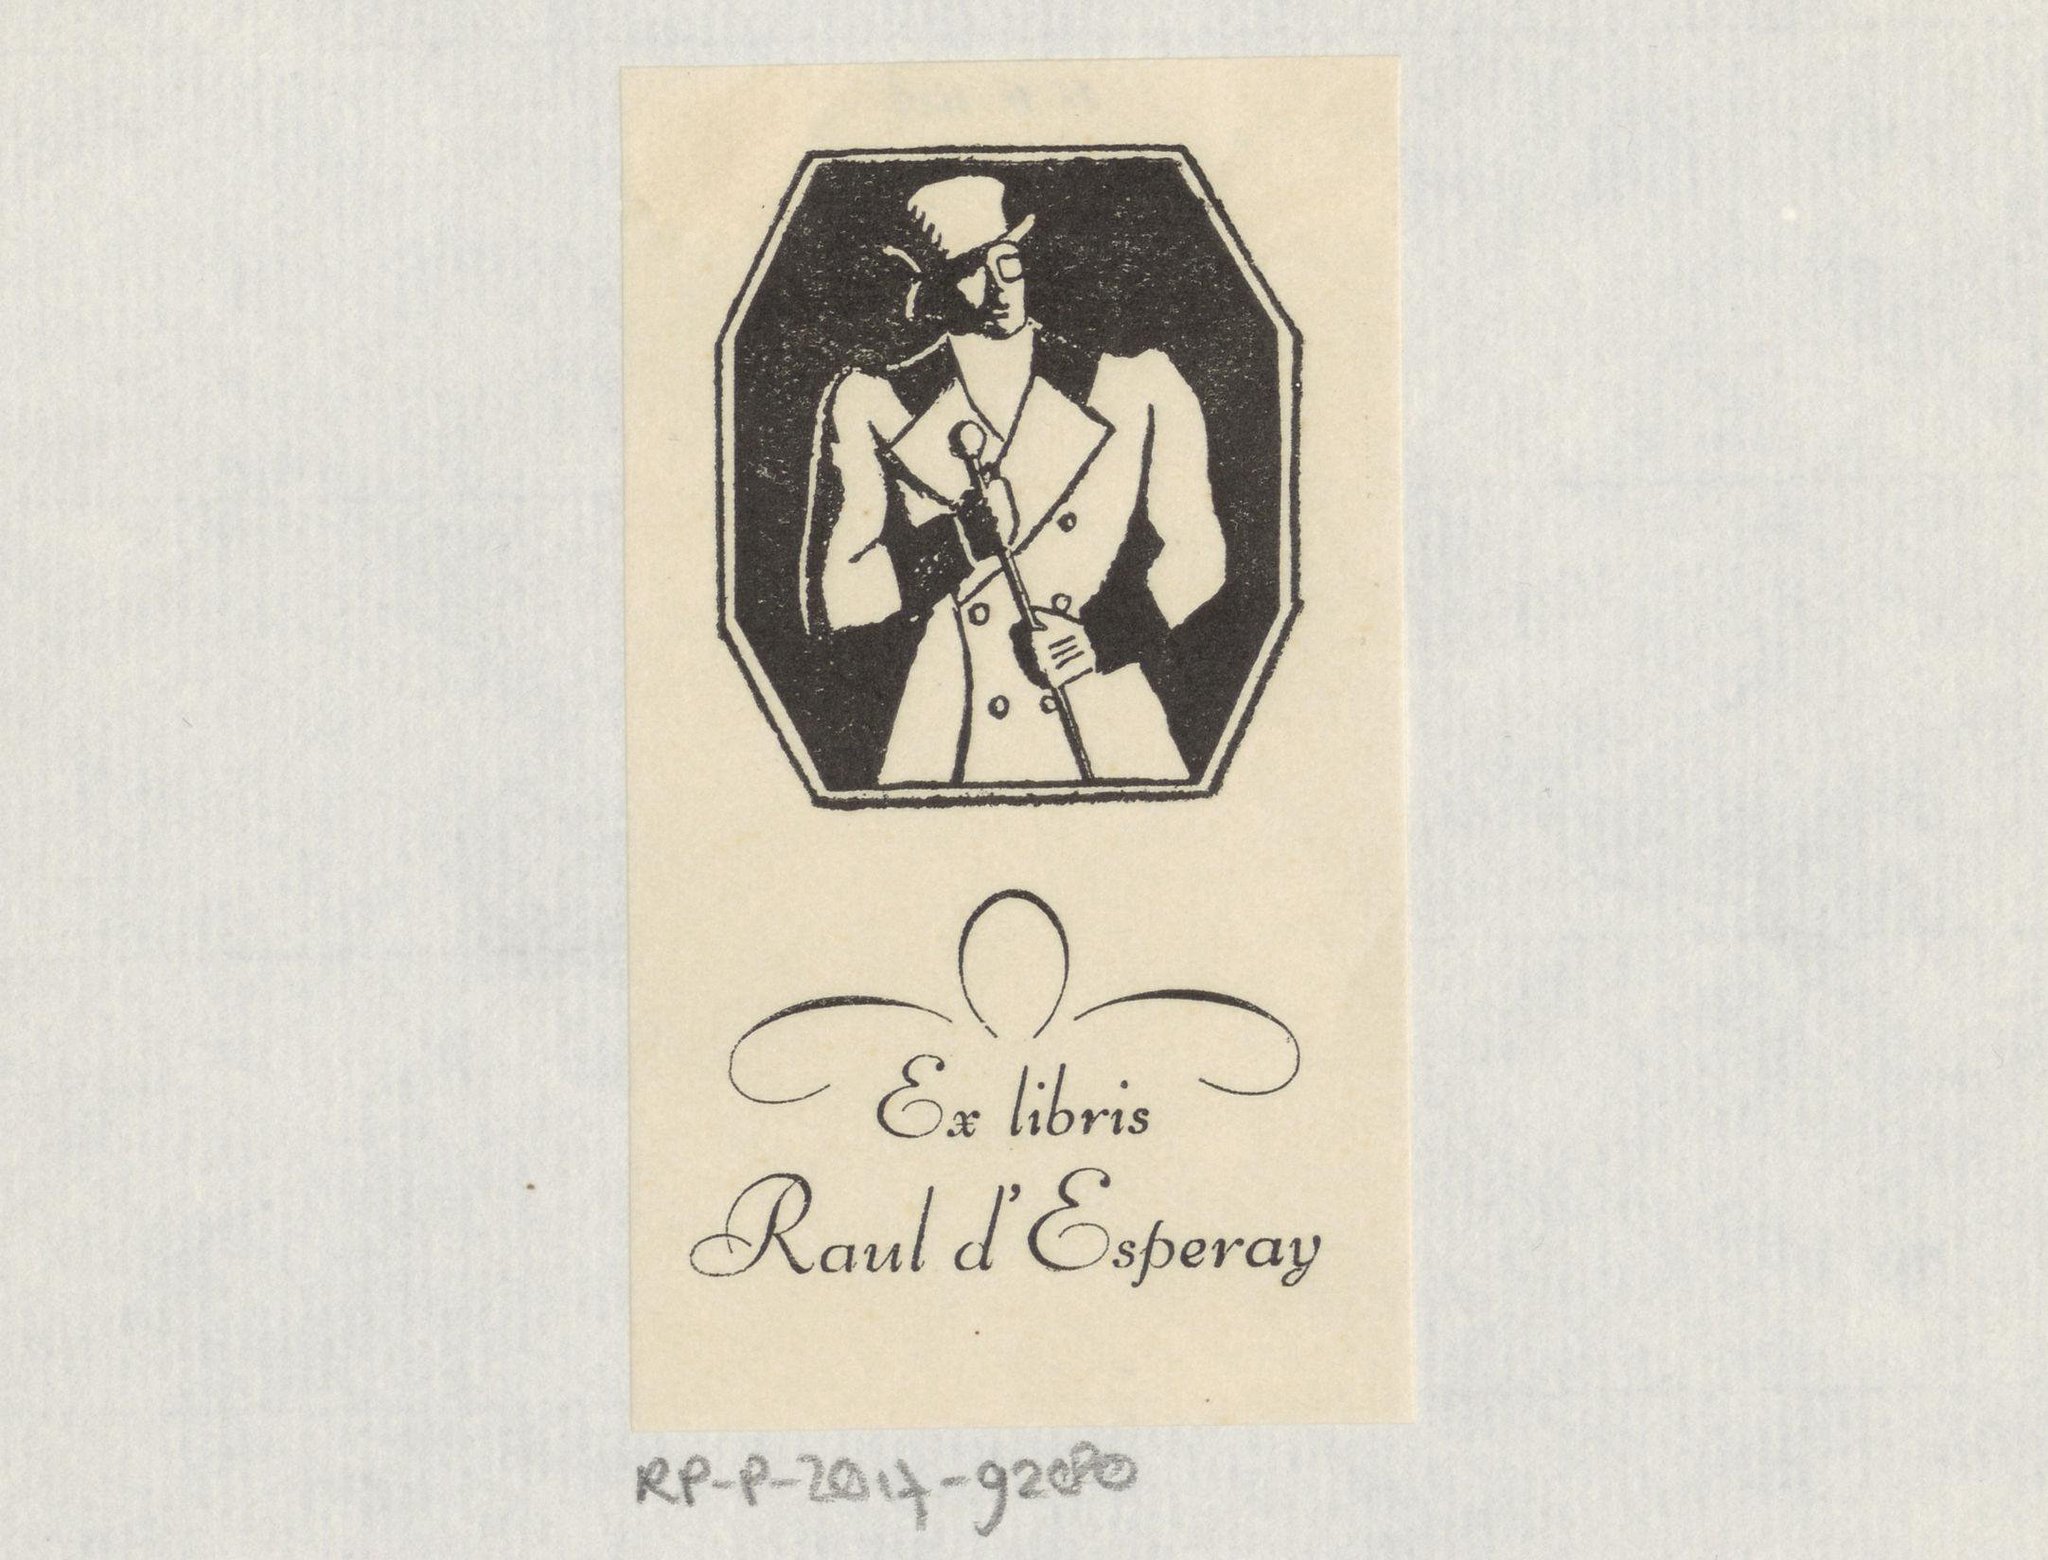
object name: bookplate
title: Ex libris van Raul d'Esperay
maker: Anonymous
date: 1934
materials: paper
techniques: printing block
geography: hungary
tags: standing figure, monocle, single lorgnette, dress, gown: evening dress